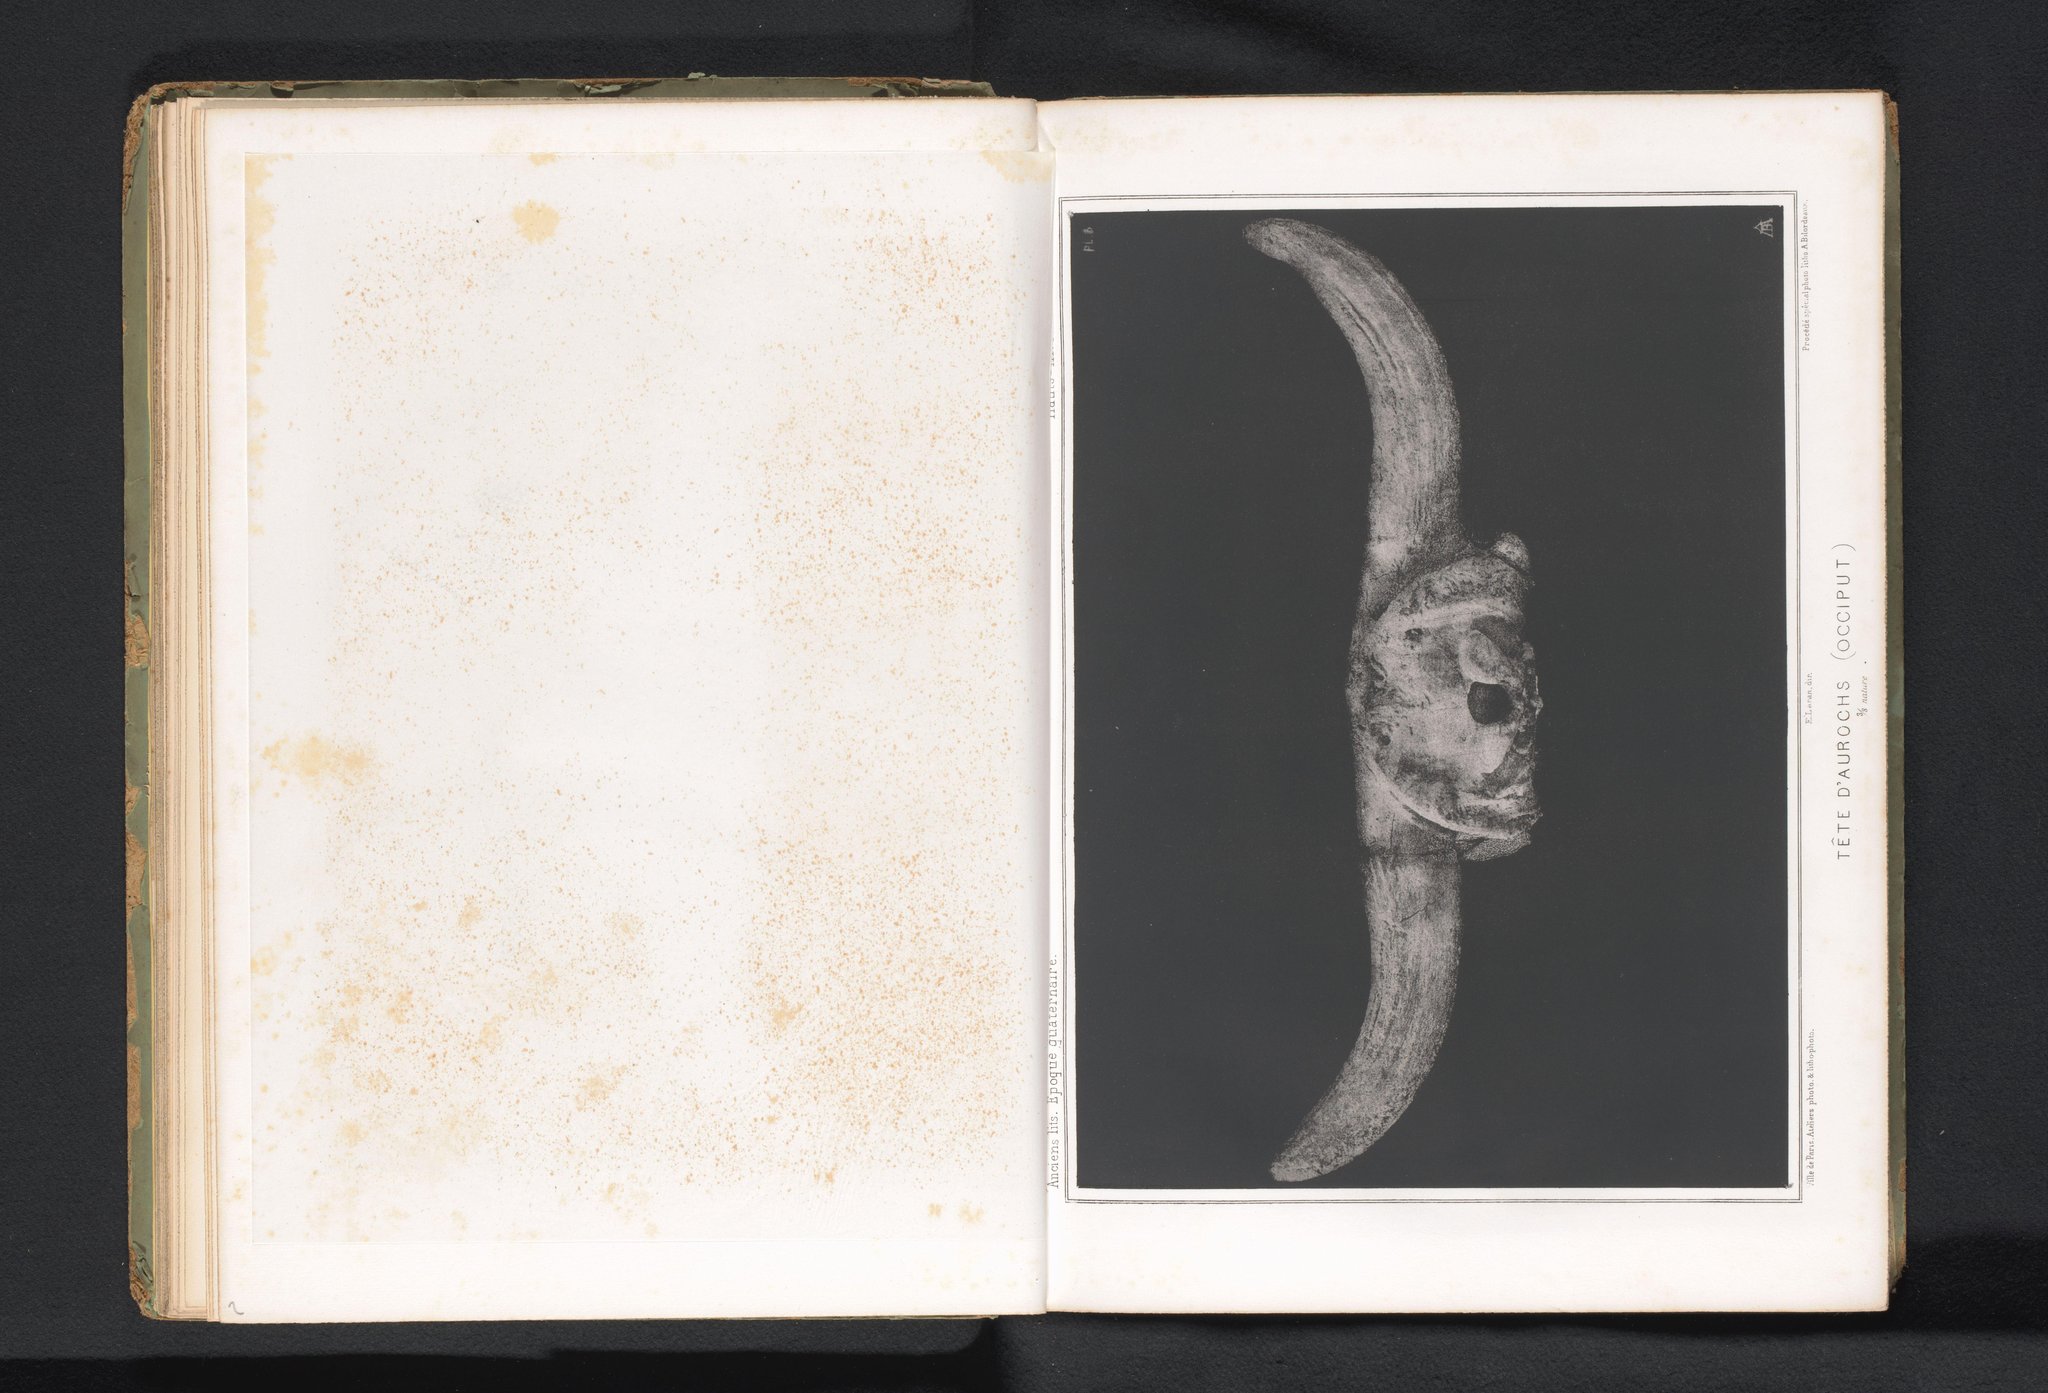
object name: page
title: Tête d'aurochs (occiput)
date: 1864-1869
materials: paper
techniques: photolithography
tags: animals (+ skeleton of an animal), palaeontology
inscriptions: monogram: ‘AB’, inscription: ‘Procedé spécial photo-litho. A. Bilordeaux’, inscription: ‘3/8 nature’, number: ‘Pl. 3’